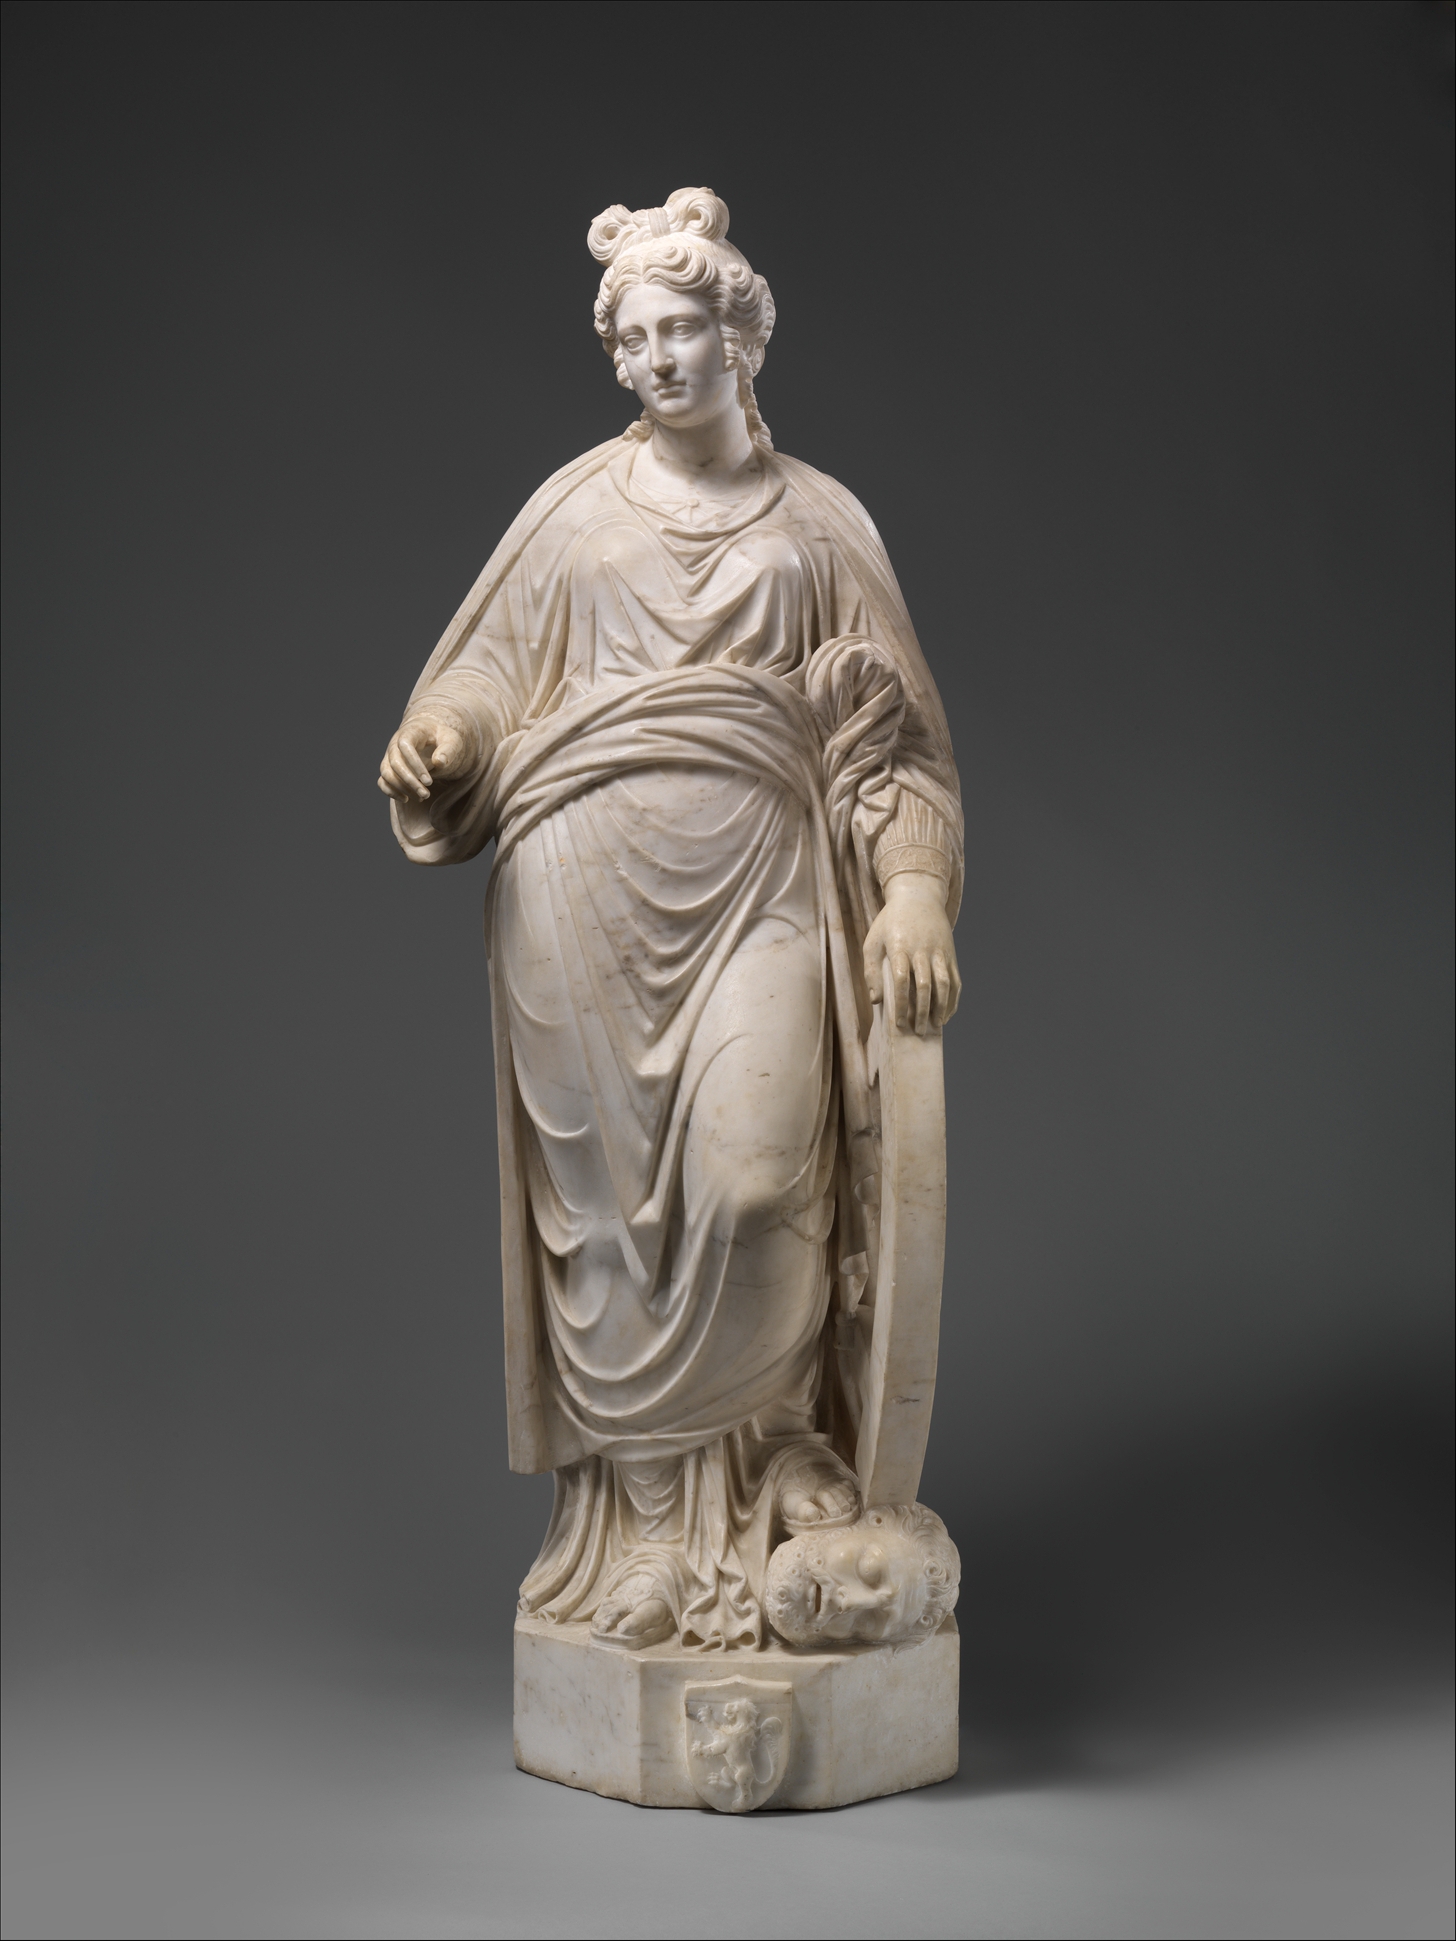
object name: statue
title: Saint Catherine of Alexandria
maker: cristoforo solari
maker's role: maker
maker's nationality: italian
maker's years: 1460-1524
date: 1514-1524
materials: marble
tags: saint catherine